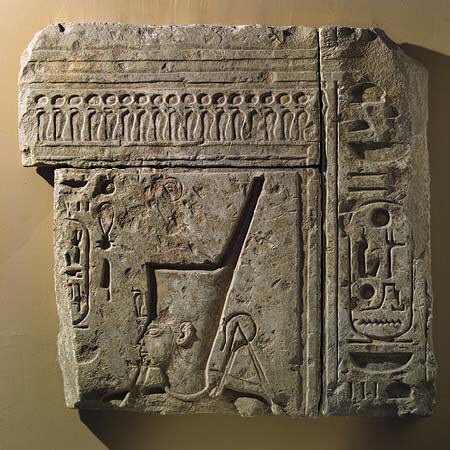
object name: relief, temple, ramesses ii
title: Jubilee Relief of Ramesses II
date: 1279-1213 BCE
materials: limestone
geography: egypt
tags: kings,men,hieroglyphs